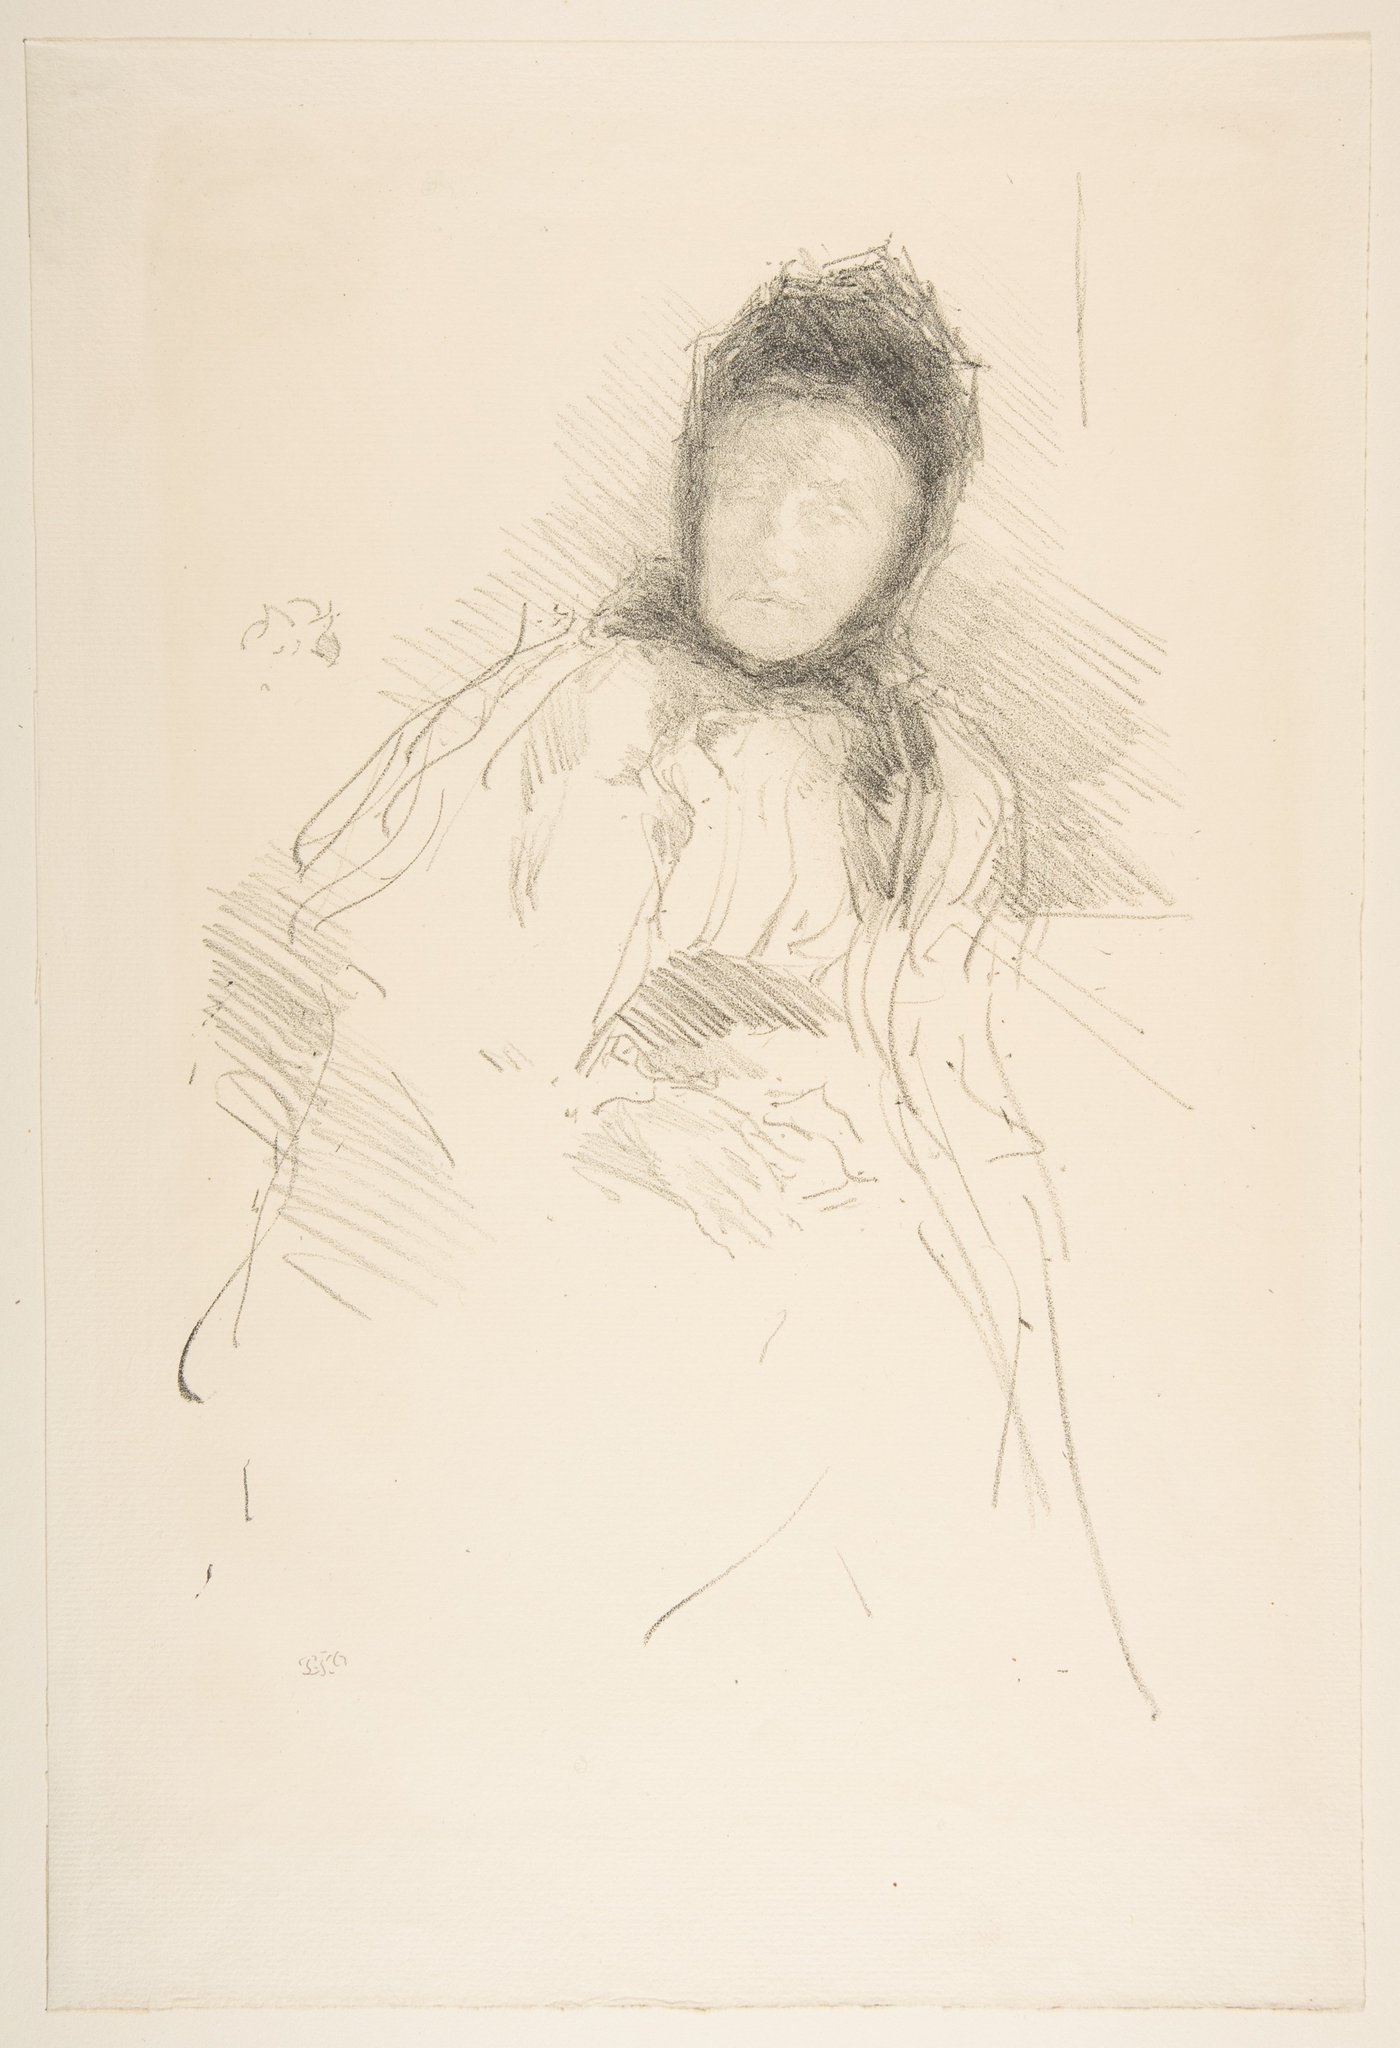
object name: print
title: Unfinished Sketch of Lady Haden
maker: james mcneill whistler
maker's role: artist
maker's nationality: american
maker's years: 1834-1903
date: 1895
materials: ink, paper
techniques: lithograph, printing, scraping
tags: women